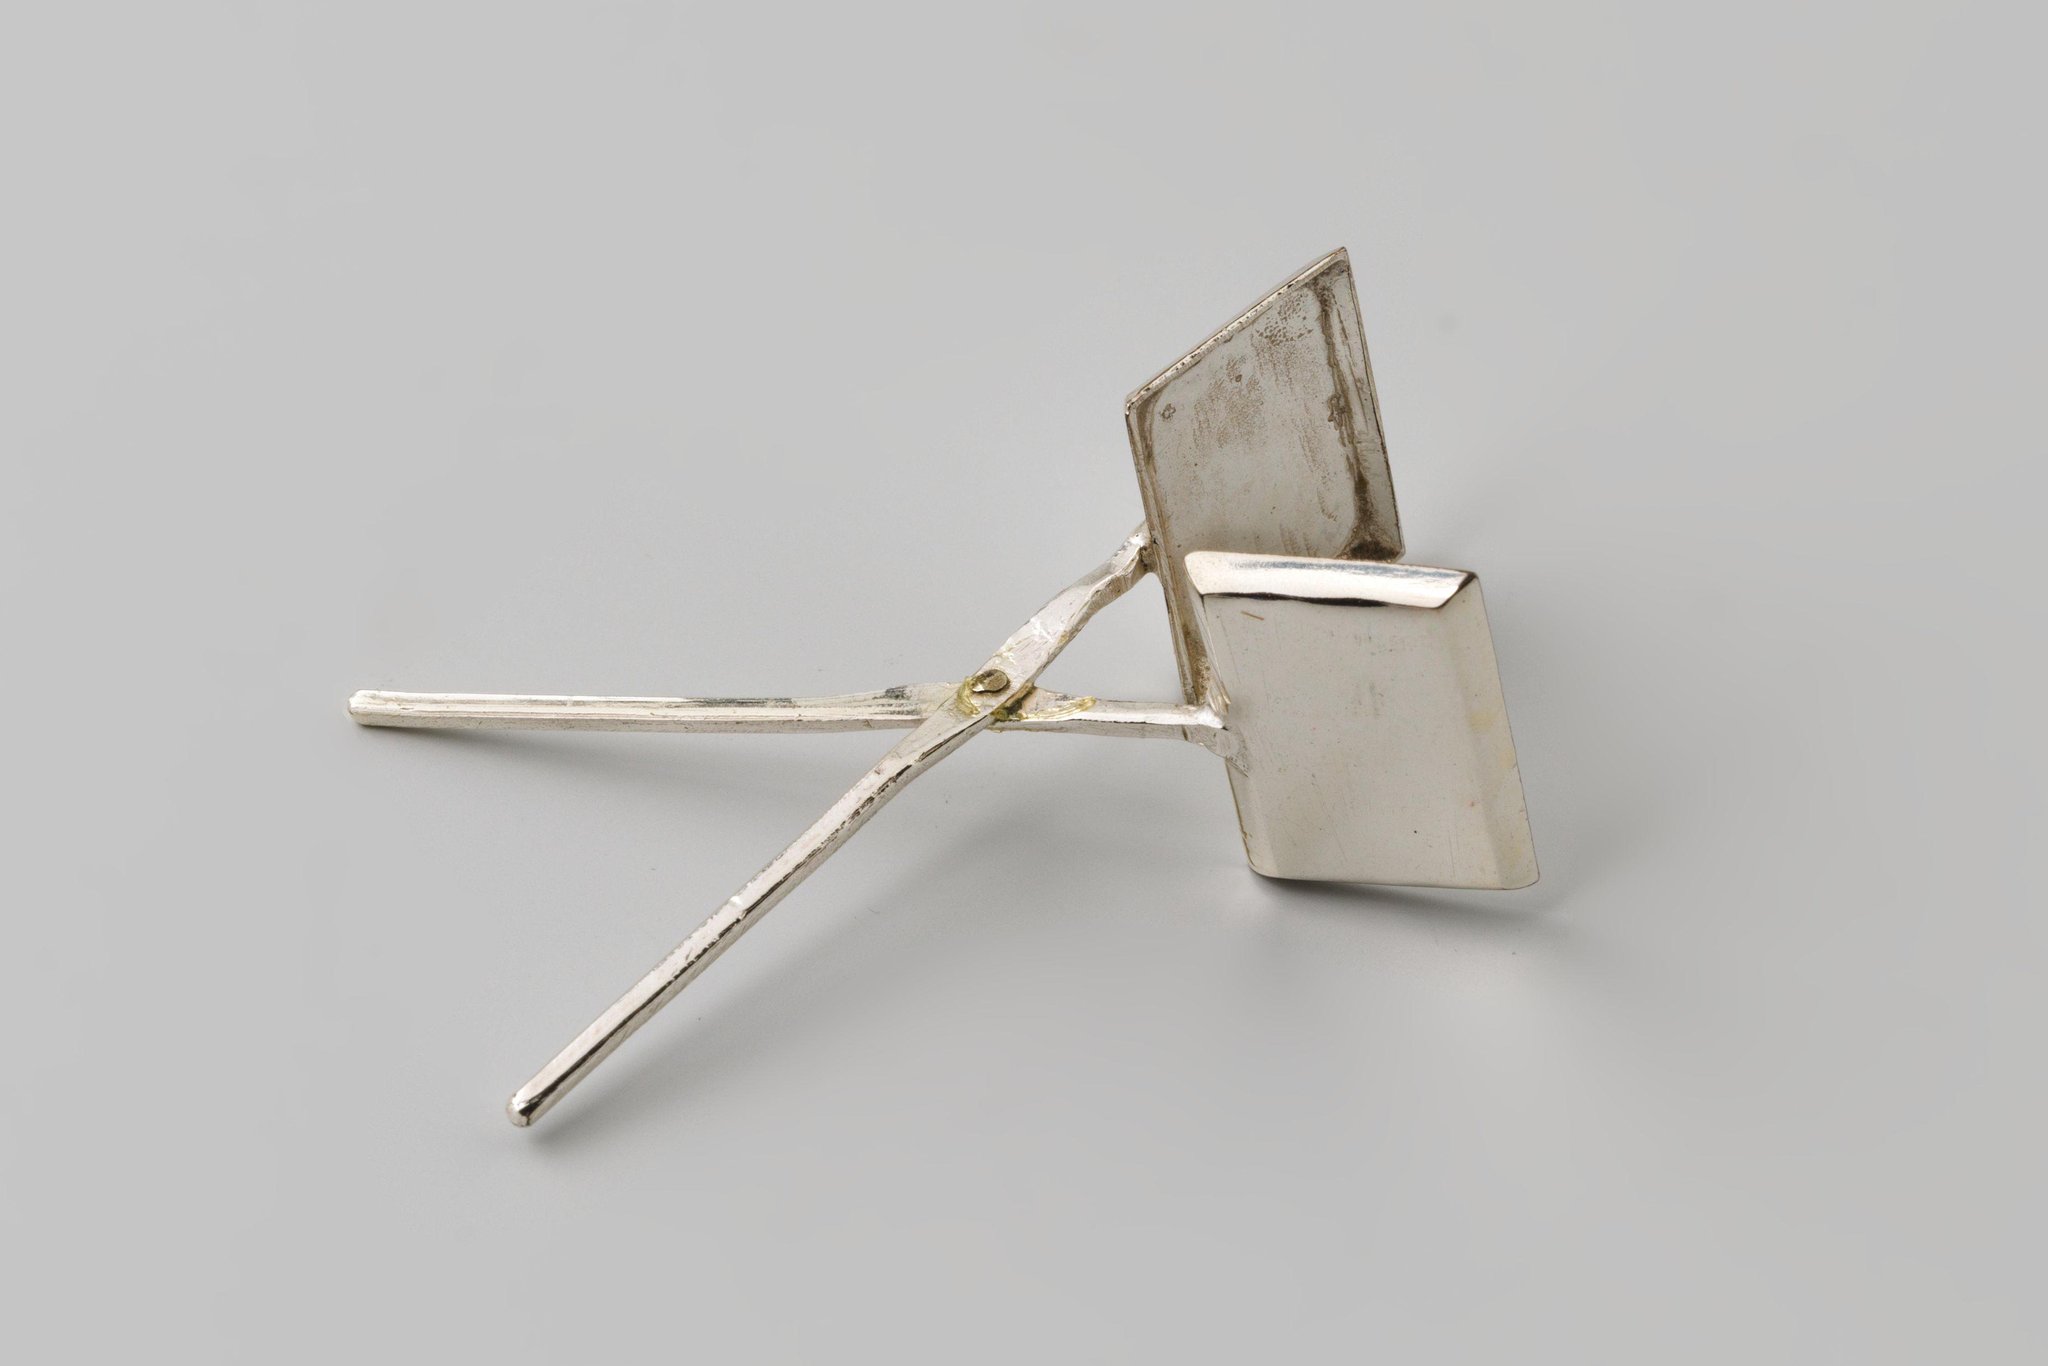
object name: waffle iron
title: Wafelijzer van zilver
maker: Anonymous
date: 1813-1906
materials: silver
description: Wafelijzer van zilver, zonder versiering en zonder wafelafdruk. Gemerkt: zwaardje.